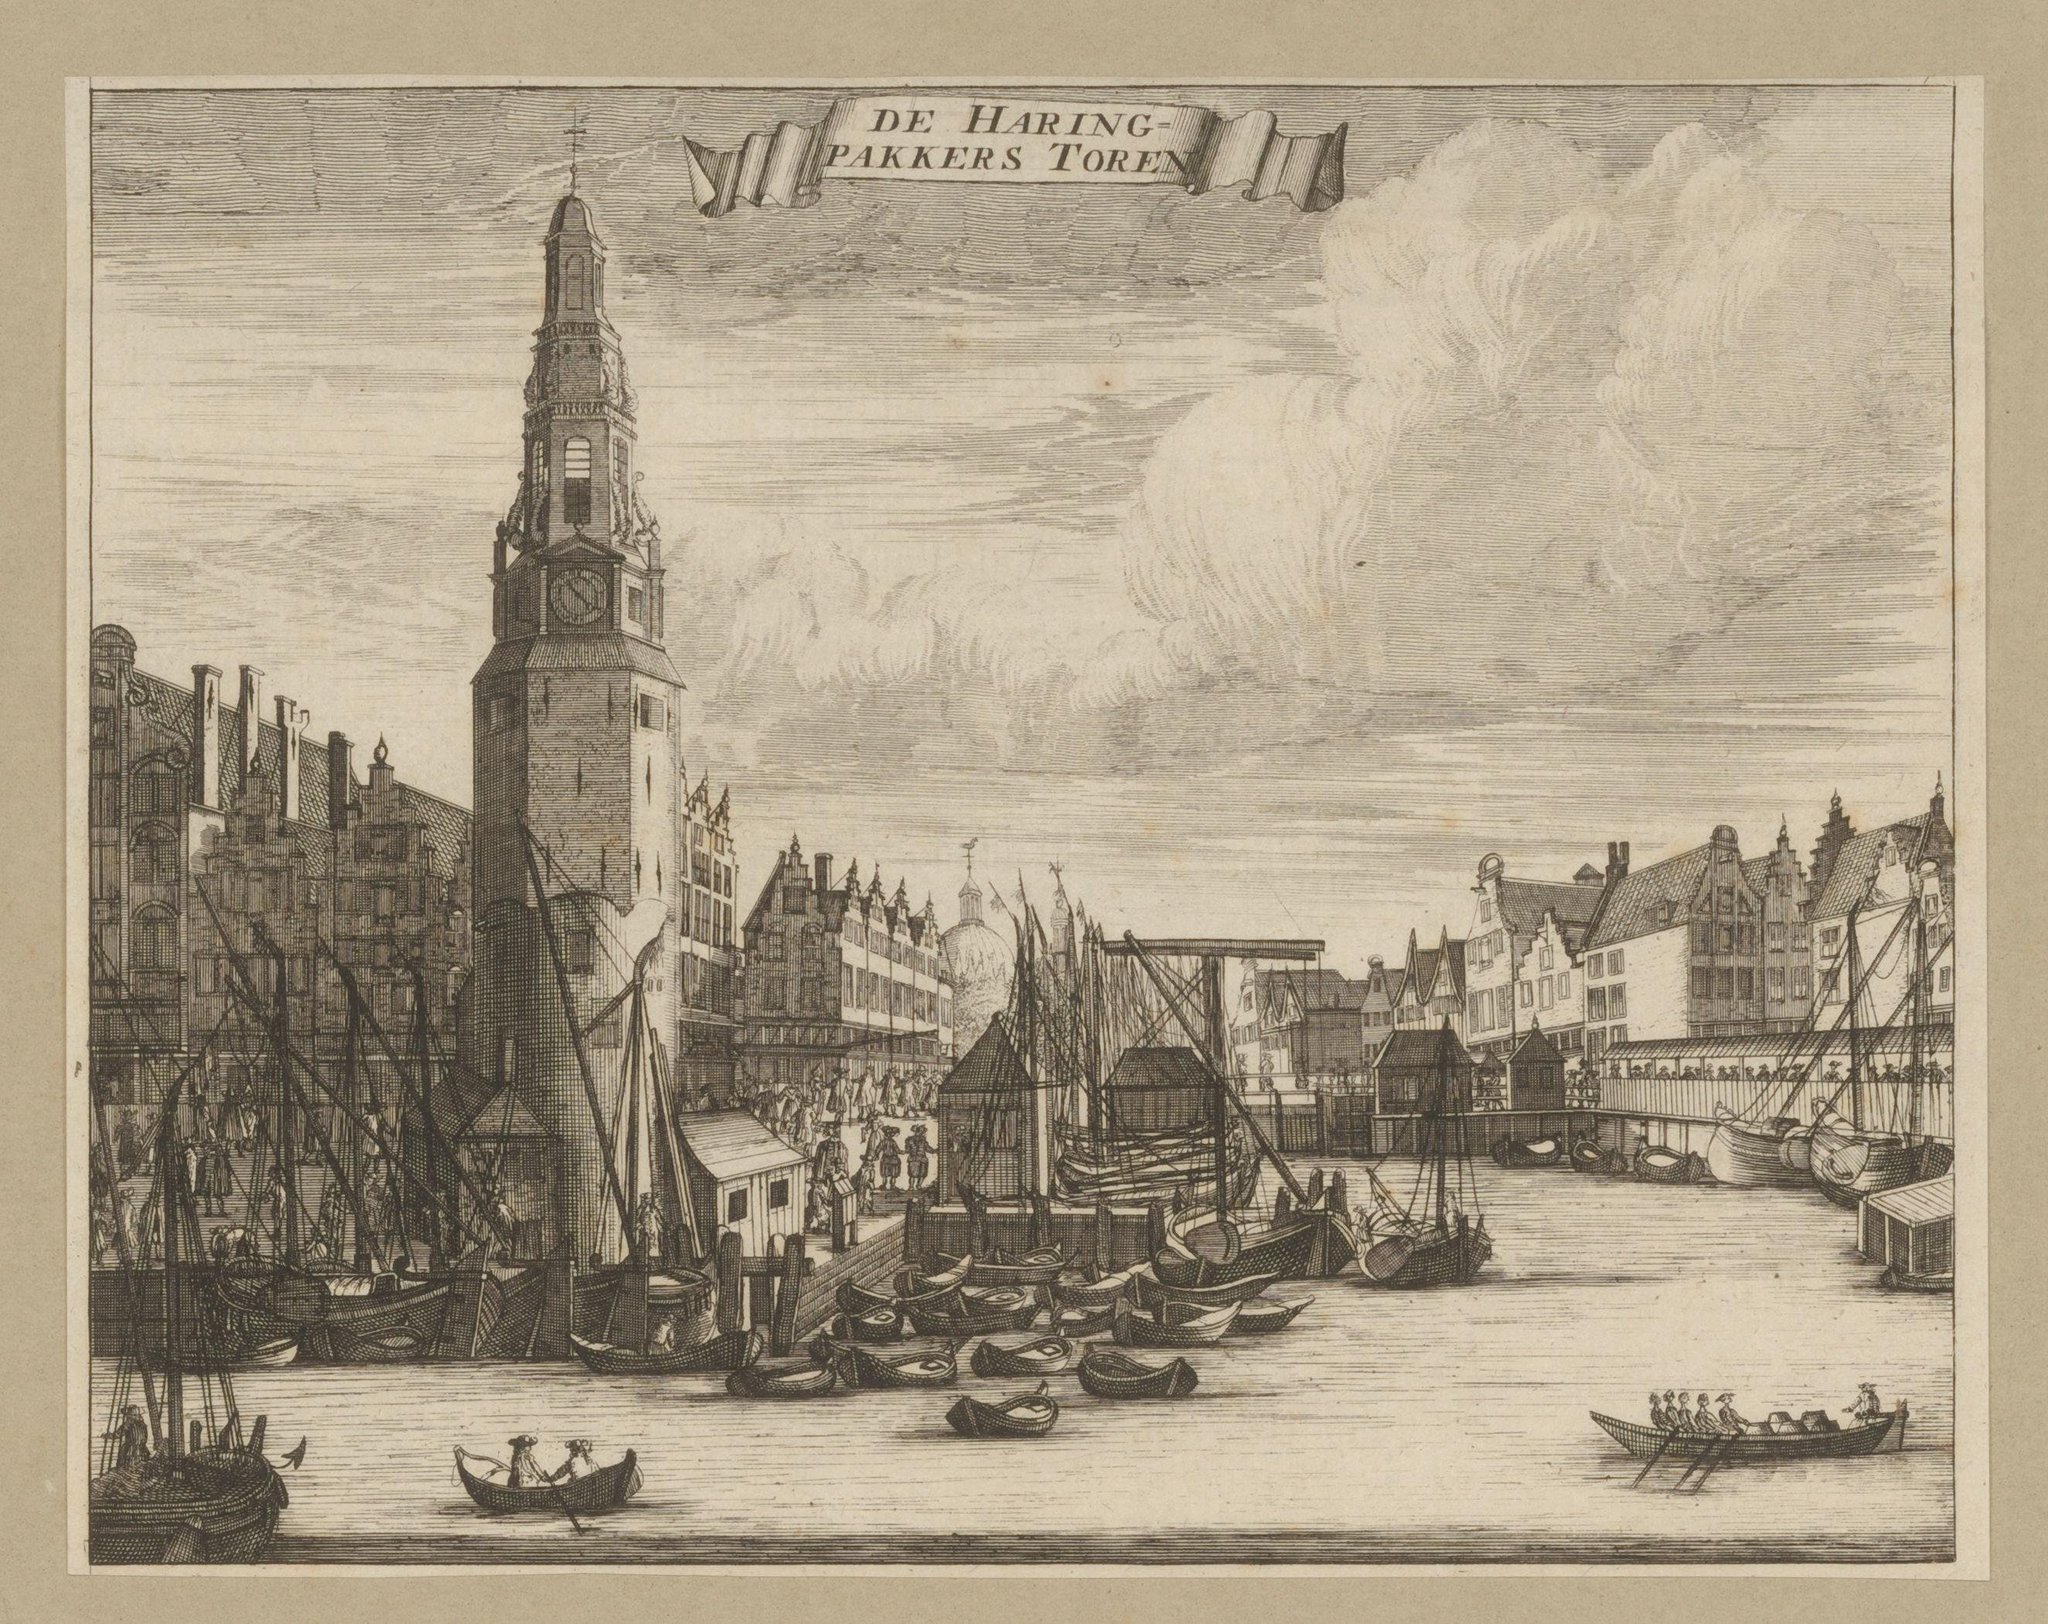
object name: print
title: Gezicht op de Haringpakkerstoren te Amsterdam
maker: Anonymous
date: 1700-1750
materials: paper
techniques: engraving, etching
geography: northern netherlands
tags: tower, clock tower ~ monumental adornment, rowing-boat, canoe, etc., canals, waters (in city)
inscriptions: collector's mark: Lugt 1641b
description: Onderwerpsrubriek binnen de Atlas Amsterdam: Haringpakkerstoren.